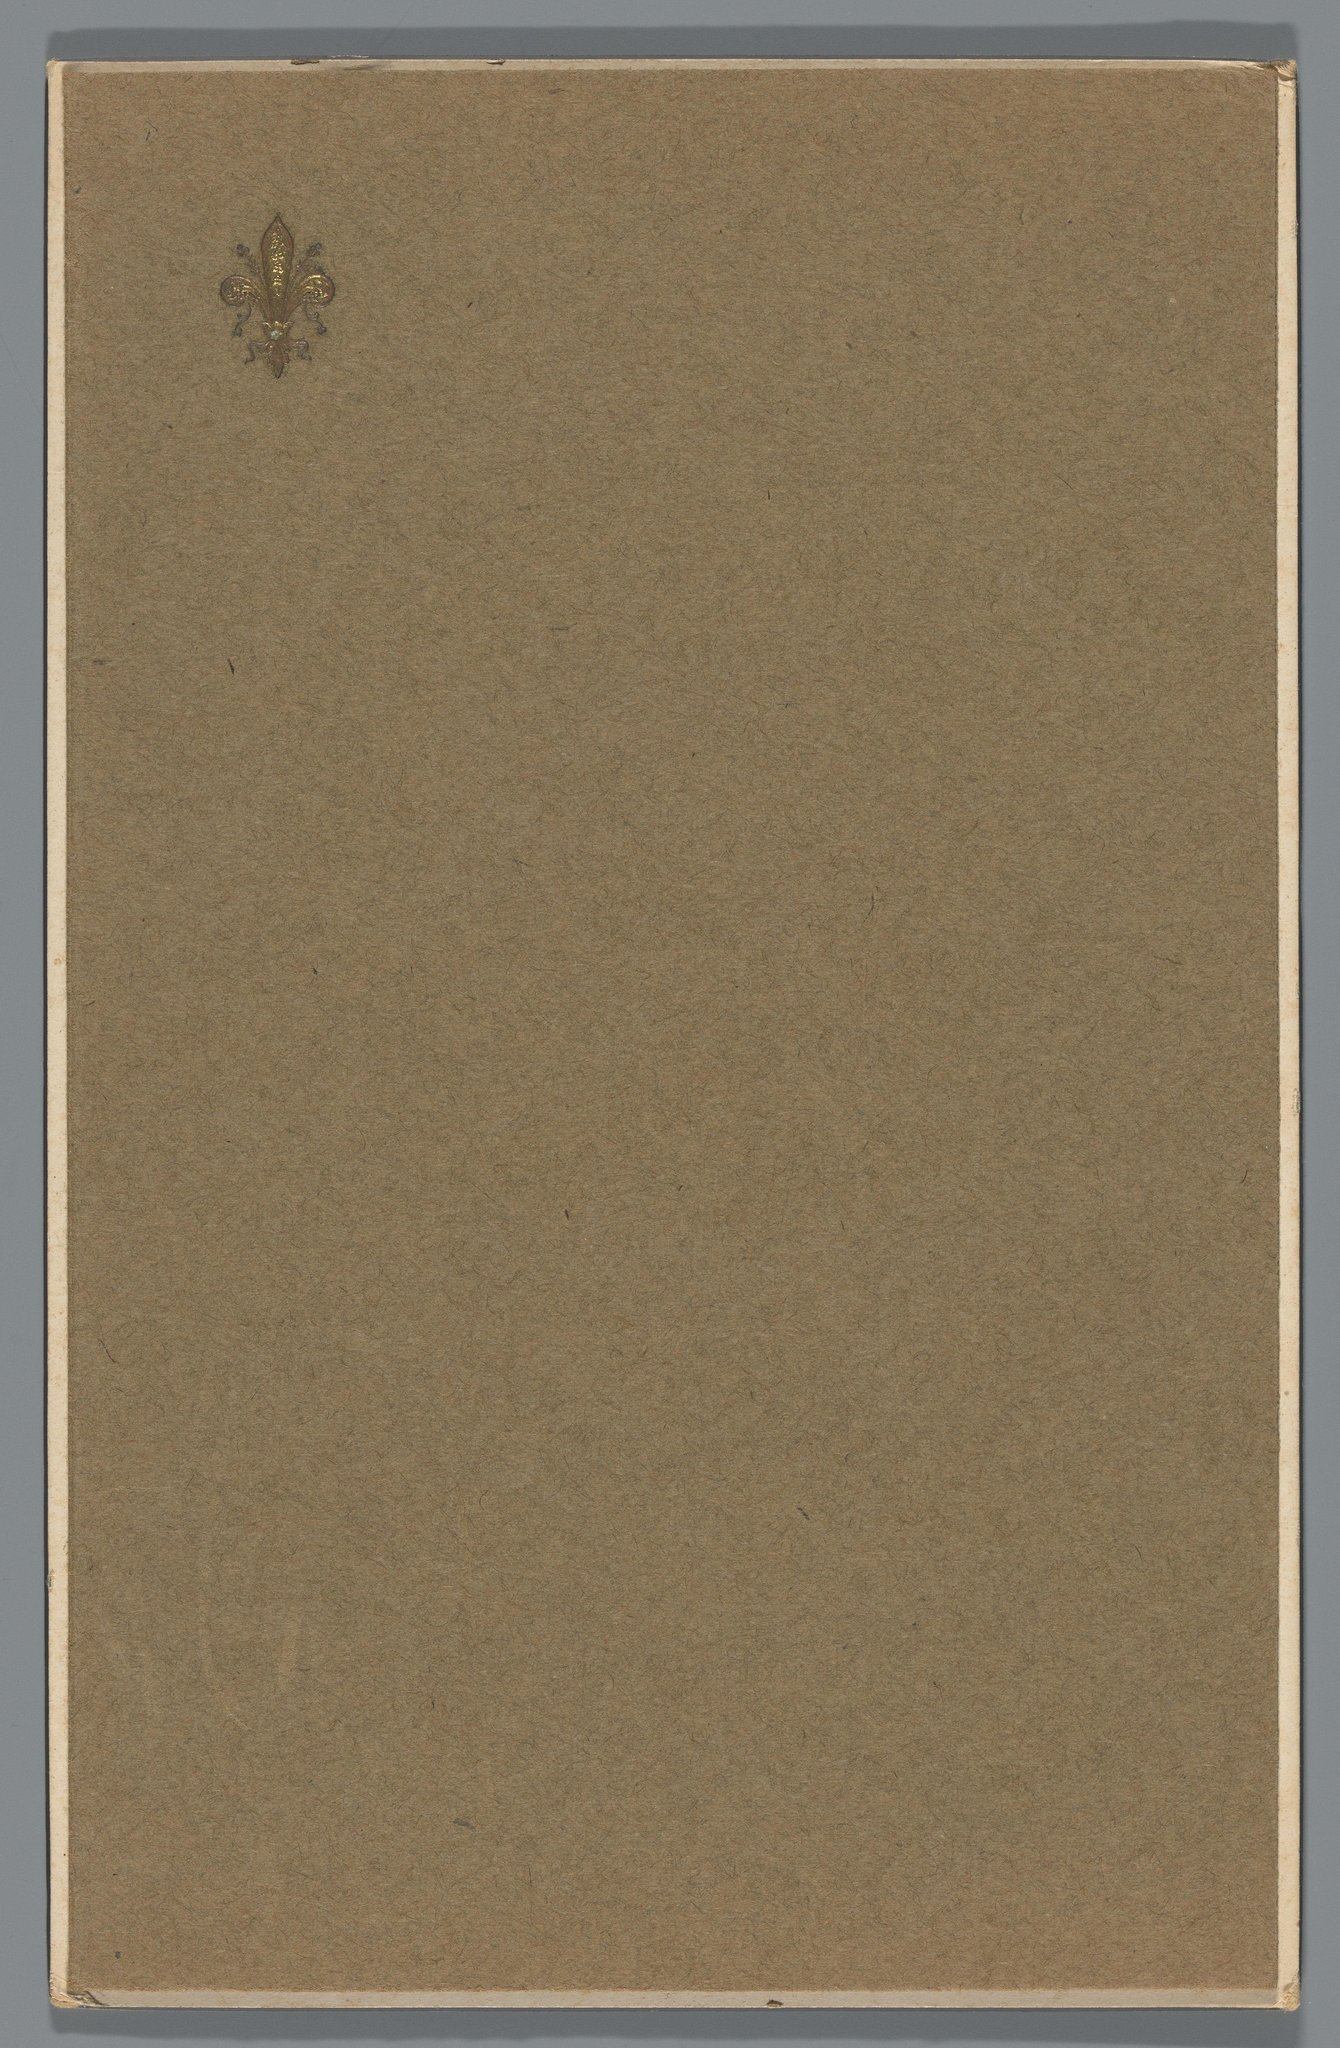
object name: photograph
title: Portret van een onbekende man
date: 1887-1920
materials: paper, cardboard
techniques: gelatin silver print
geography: amsterdam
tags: historical persons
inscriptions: address: ‘Koene & Büttinghausen/ AMSTERDAM/ Heerengracht 150’